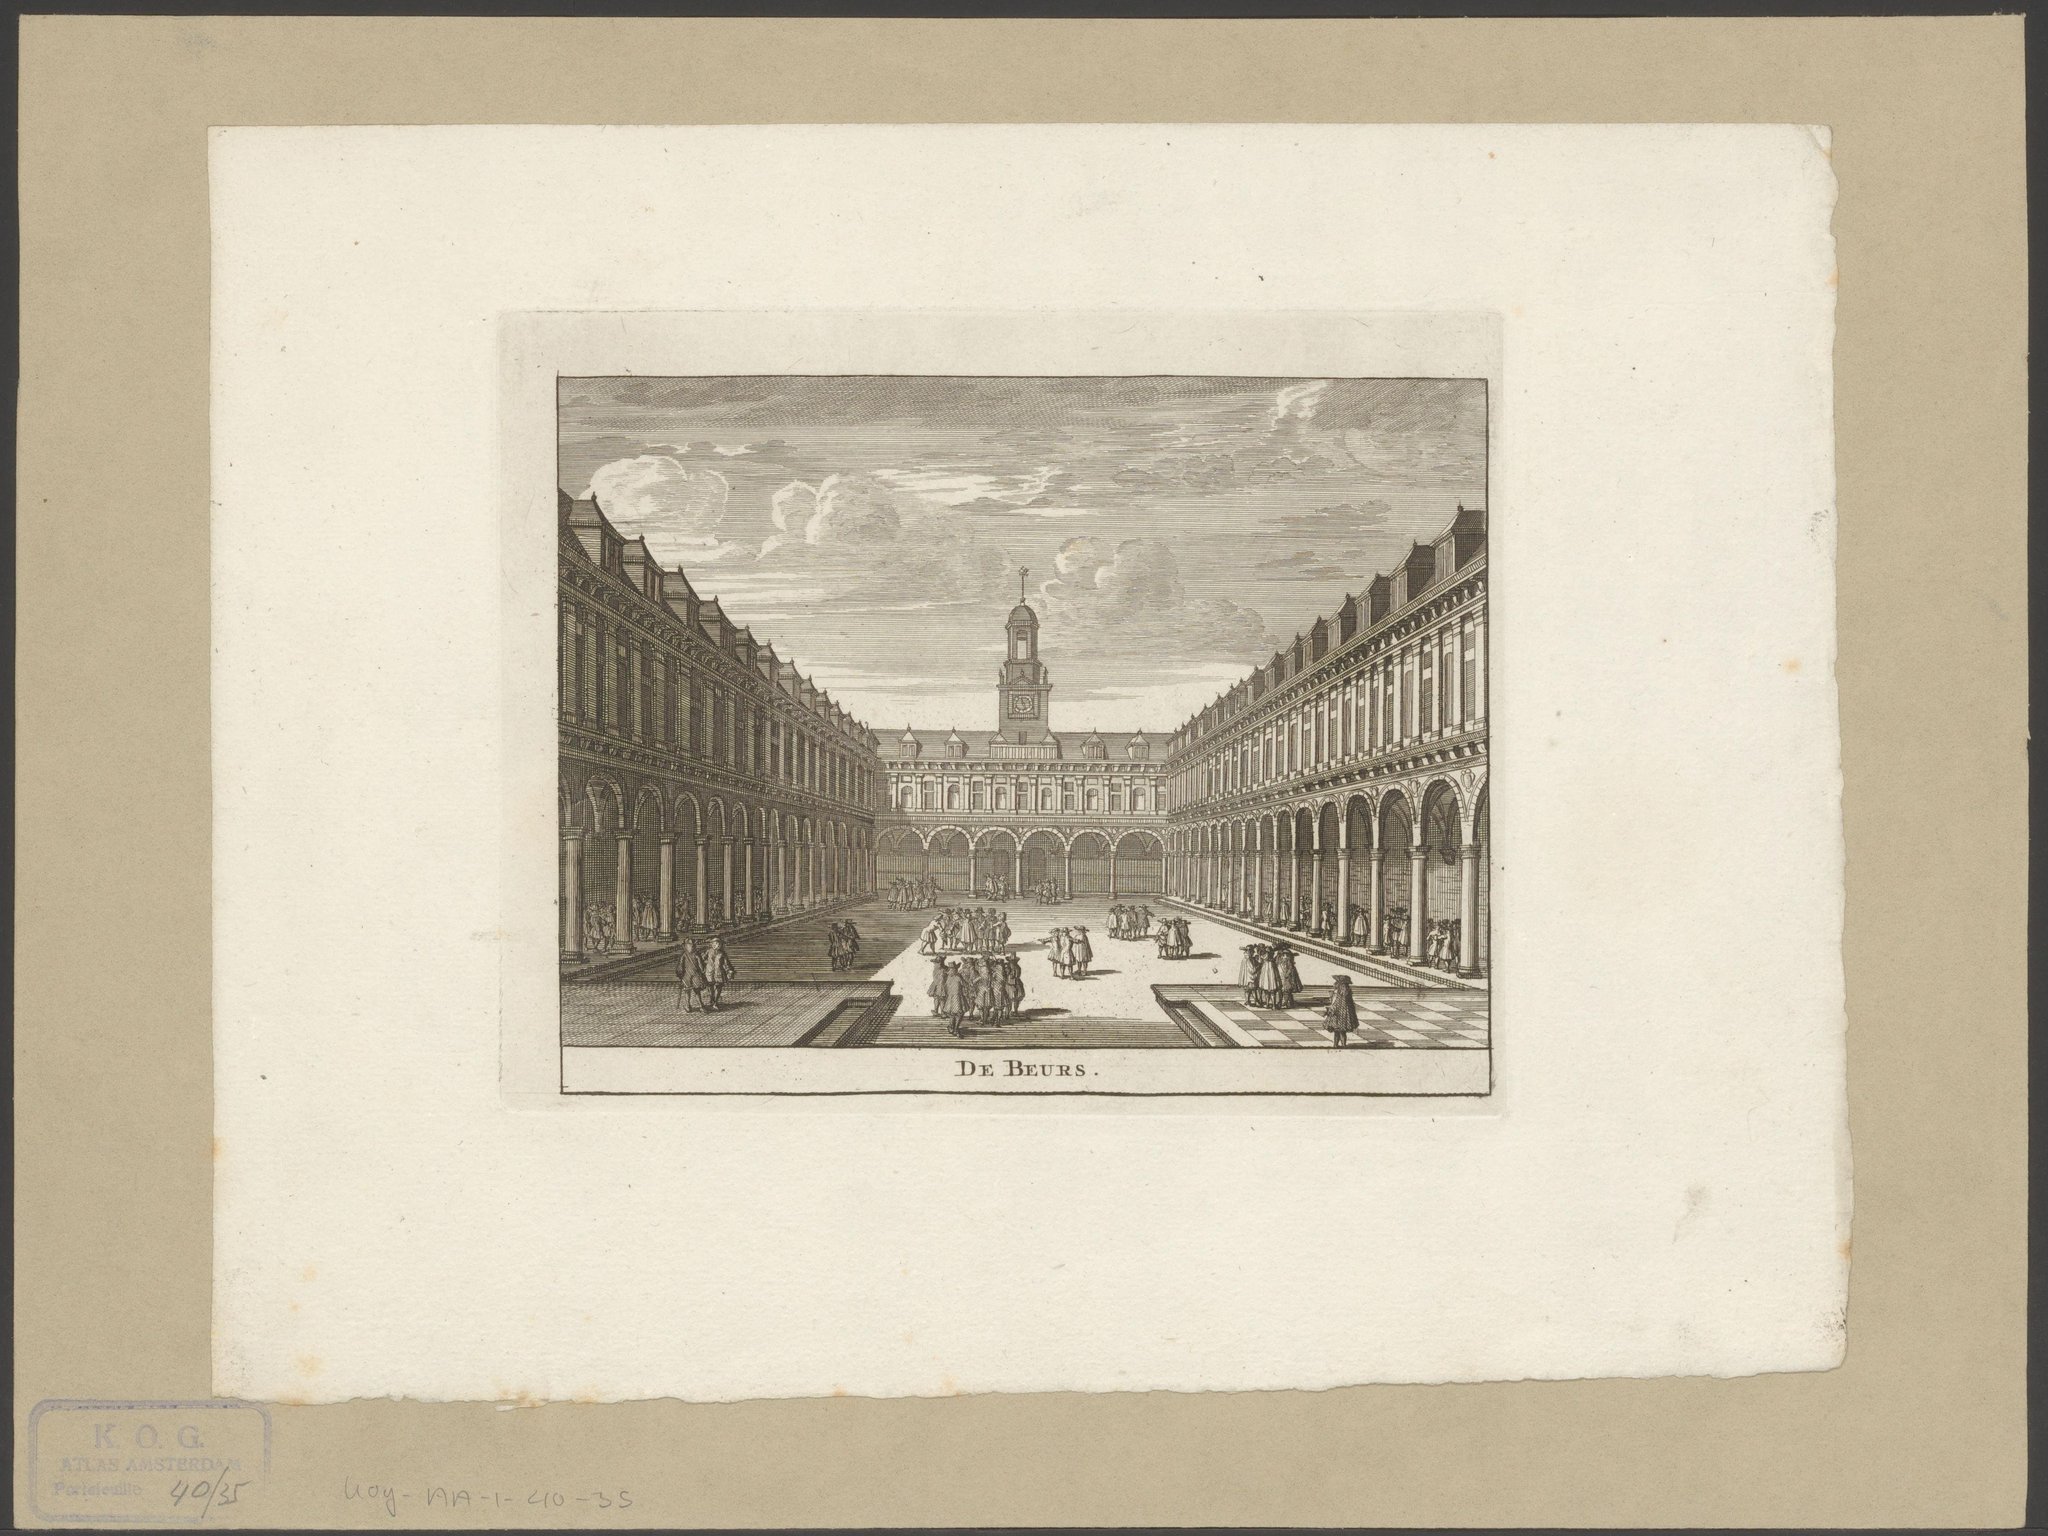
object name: print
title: Gezicht op de binnenplaats van de Beurs van Hendrik de Keyser te Amsterdam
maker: Anonymous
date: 1751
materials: paper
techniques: engraving, etching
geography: northern netherlands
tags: stock exchange, stock-market, courtyard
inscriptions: collector's mark: Lugt 1641b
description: Eerste staat van prent, genummerd 287, gebruikt in: Hoorn, Nicolaas ten. Wegwyzer door Amsterdam zynde eene beknopte verhandeling van desselfs eerste opkomst, vergrootingen, en teegenwoordigen staat (...). Amsterdam: Nicolaas ten Hoorn, 1713. En in: Hoorn, Nicolaas ten. Wegwyzer door Amsterdam zynde eene beknopte verhandeling van desselfs eerste opkomst, vergrootingen, en teegenwoordigen staat (...). Amsterdam: Nicolaas ten Hoorn, 1726. Tweede staat van prent, genummerd 306, gebruikt in: Hoorn, Nicolaas ten. Wegwyzer door Amsterdam zynde eene beknopte verhandeling van desselfs eerste opkomst, vergrootingen, en teegenwoordigen staat (...). Amsterdam: Nicolaas ten Hoorn, 1726. En in: Hoorn, Nicolaas ten. Wegwyzer, of korte beschryvinge van de stadt Amsterdam, zynde eene beknopte verhandeling van desselfs eerste opkomst, vergrootingen, en teegenwoordigen staat (...). Amsterdam: erven J. Ratelband & Co, 1737. En in: Hoorn, Nicolaas ten. Wegwyzer of korte beschryvinge der stad Amsterdam, zynde eene beknopte verhandeling van derzelver eerste opkomst, vergrootingen, en tegenwoordigen staat (...). Amsterdam: Pieter Meyer, 1751.